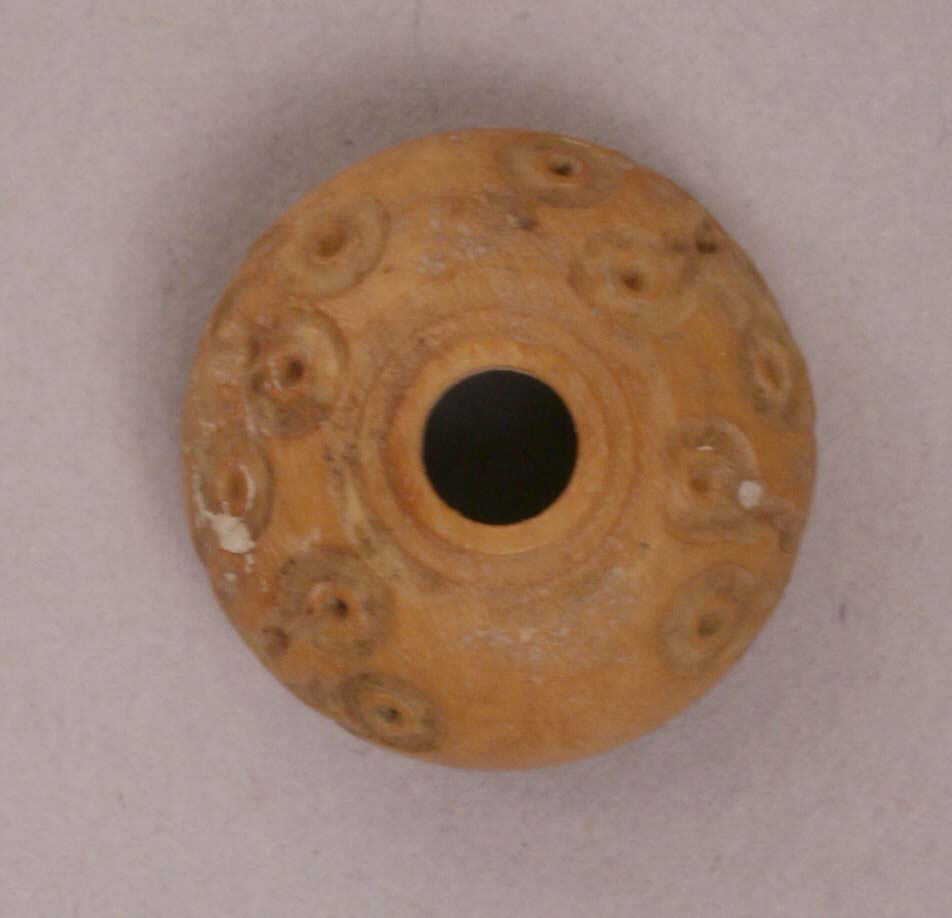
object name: button or bead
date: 801-1000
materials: bone, paint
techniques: incising, inlay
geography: iran